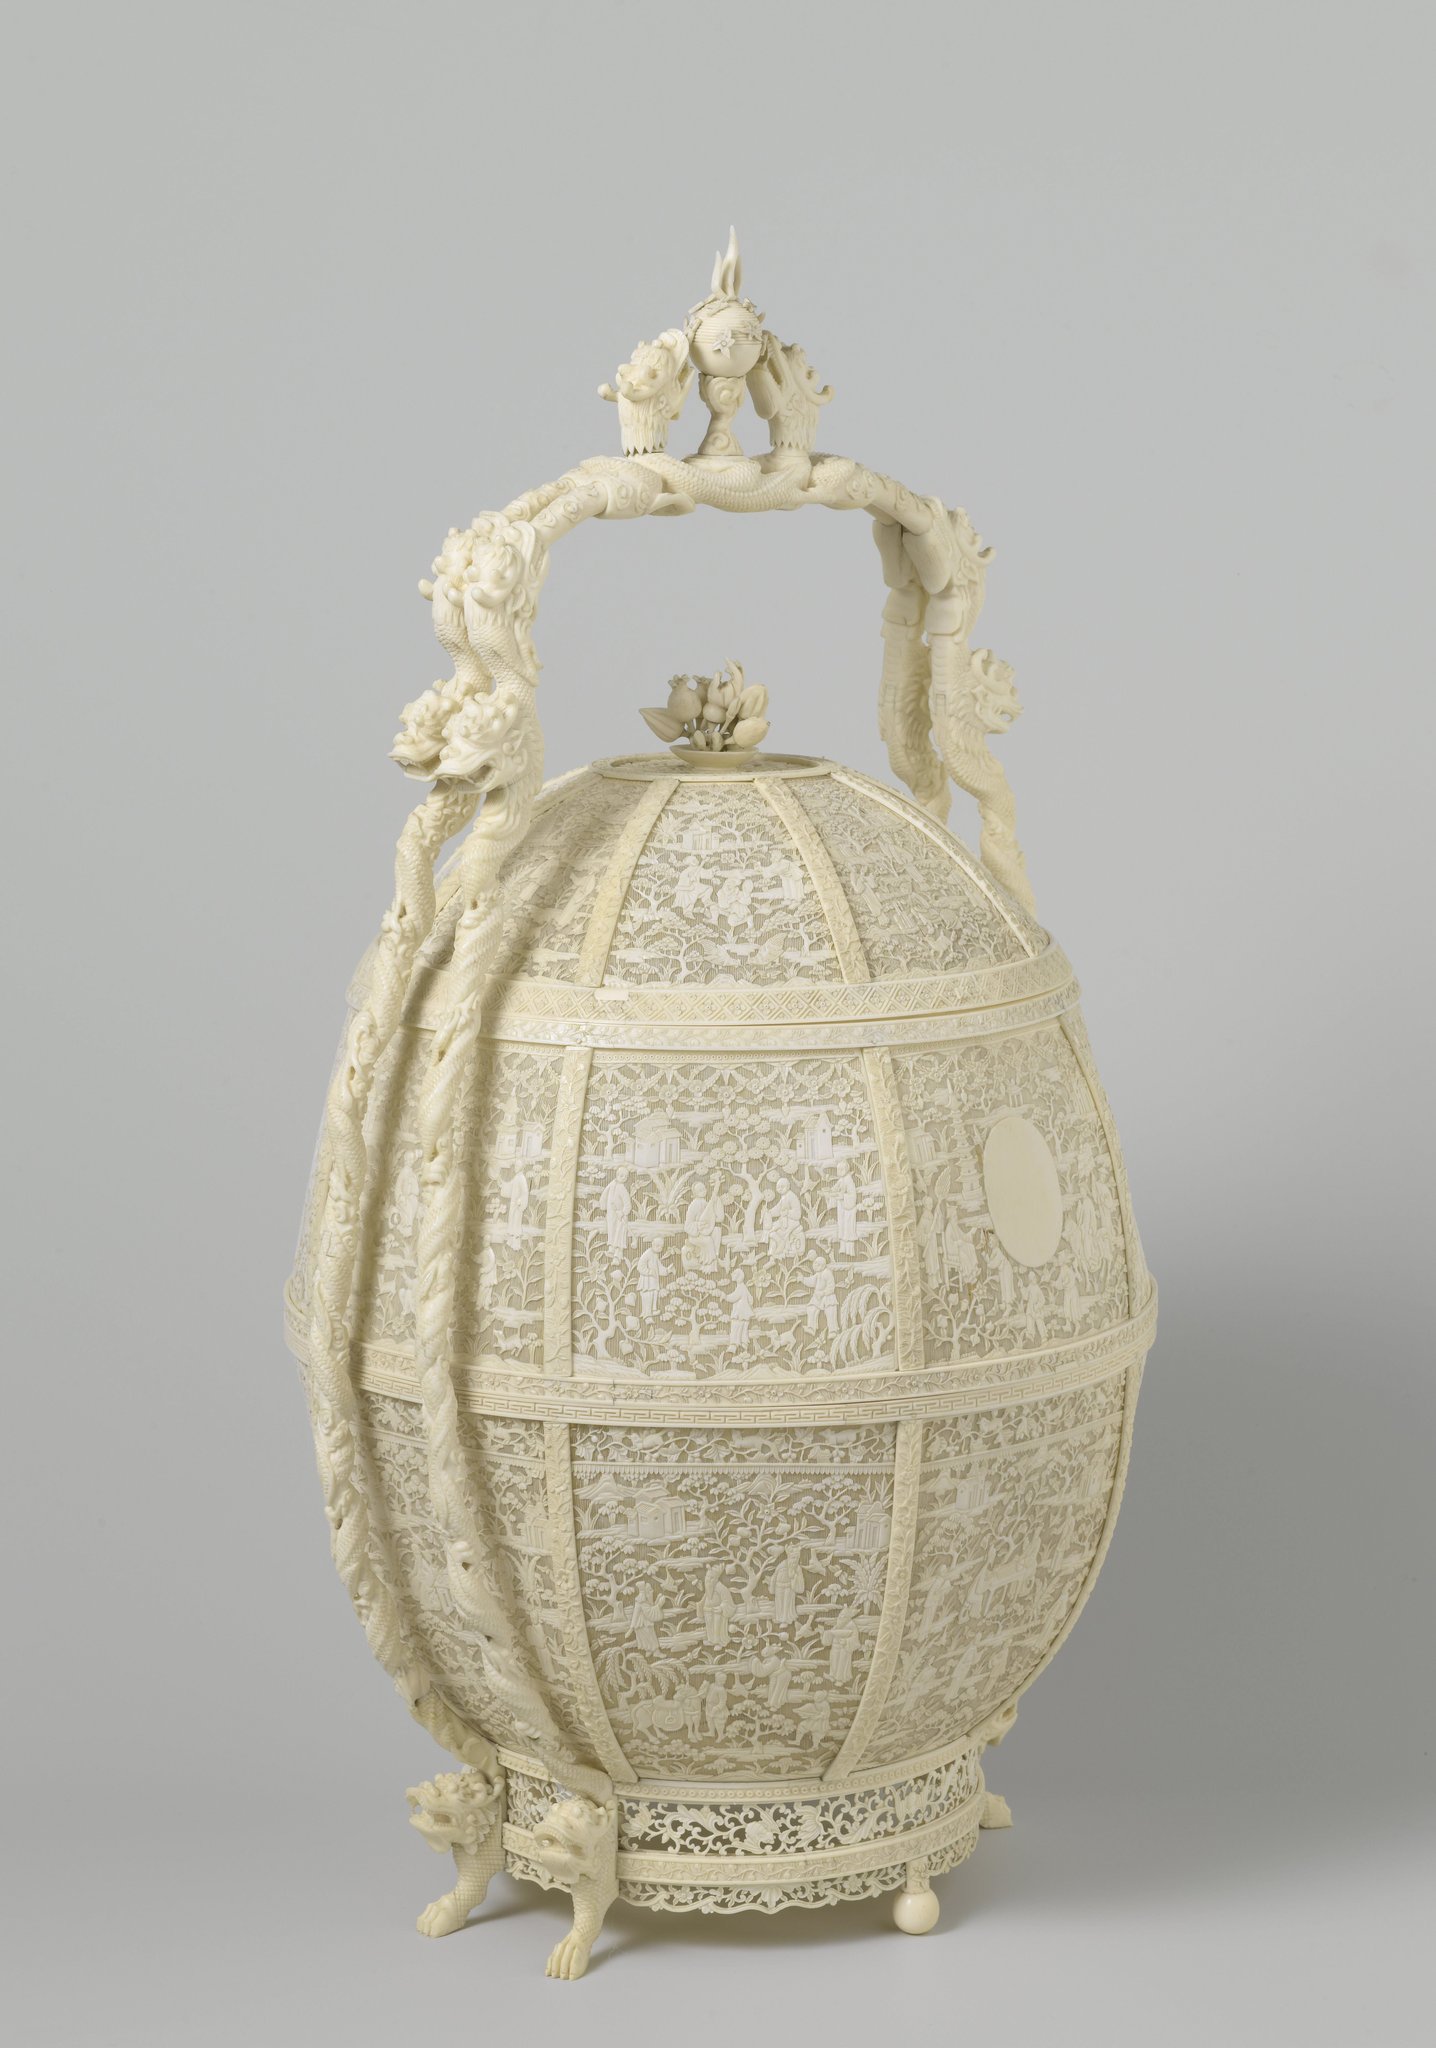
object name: stapeldoos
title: Stacking box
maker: Anonymous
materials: ivory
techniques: cutting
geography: guangdong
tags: dragon, ornament derived from plant forms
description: This pair of stacking boxes is exceedingly finely incised with figures in a detailed landscape. The boxes’ almost transparent carving indicates that they did not serve a utilitarian, but rather a decorative purpose. Due to global trade, Canton became the most important centre for processing and selling ivory. This type of openwork ivory ranks among the most costly souvenirs one could buy in Canton.